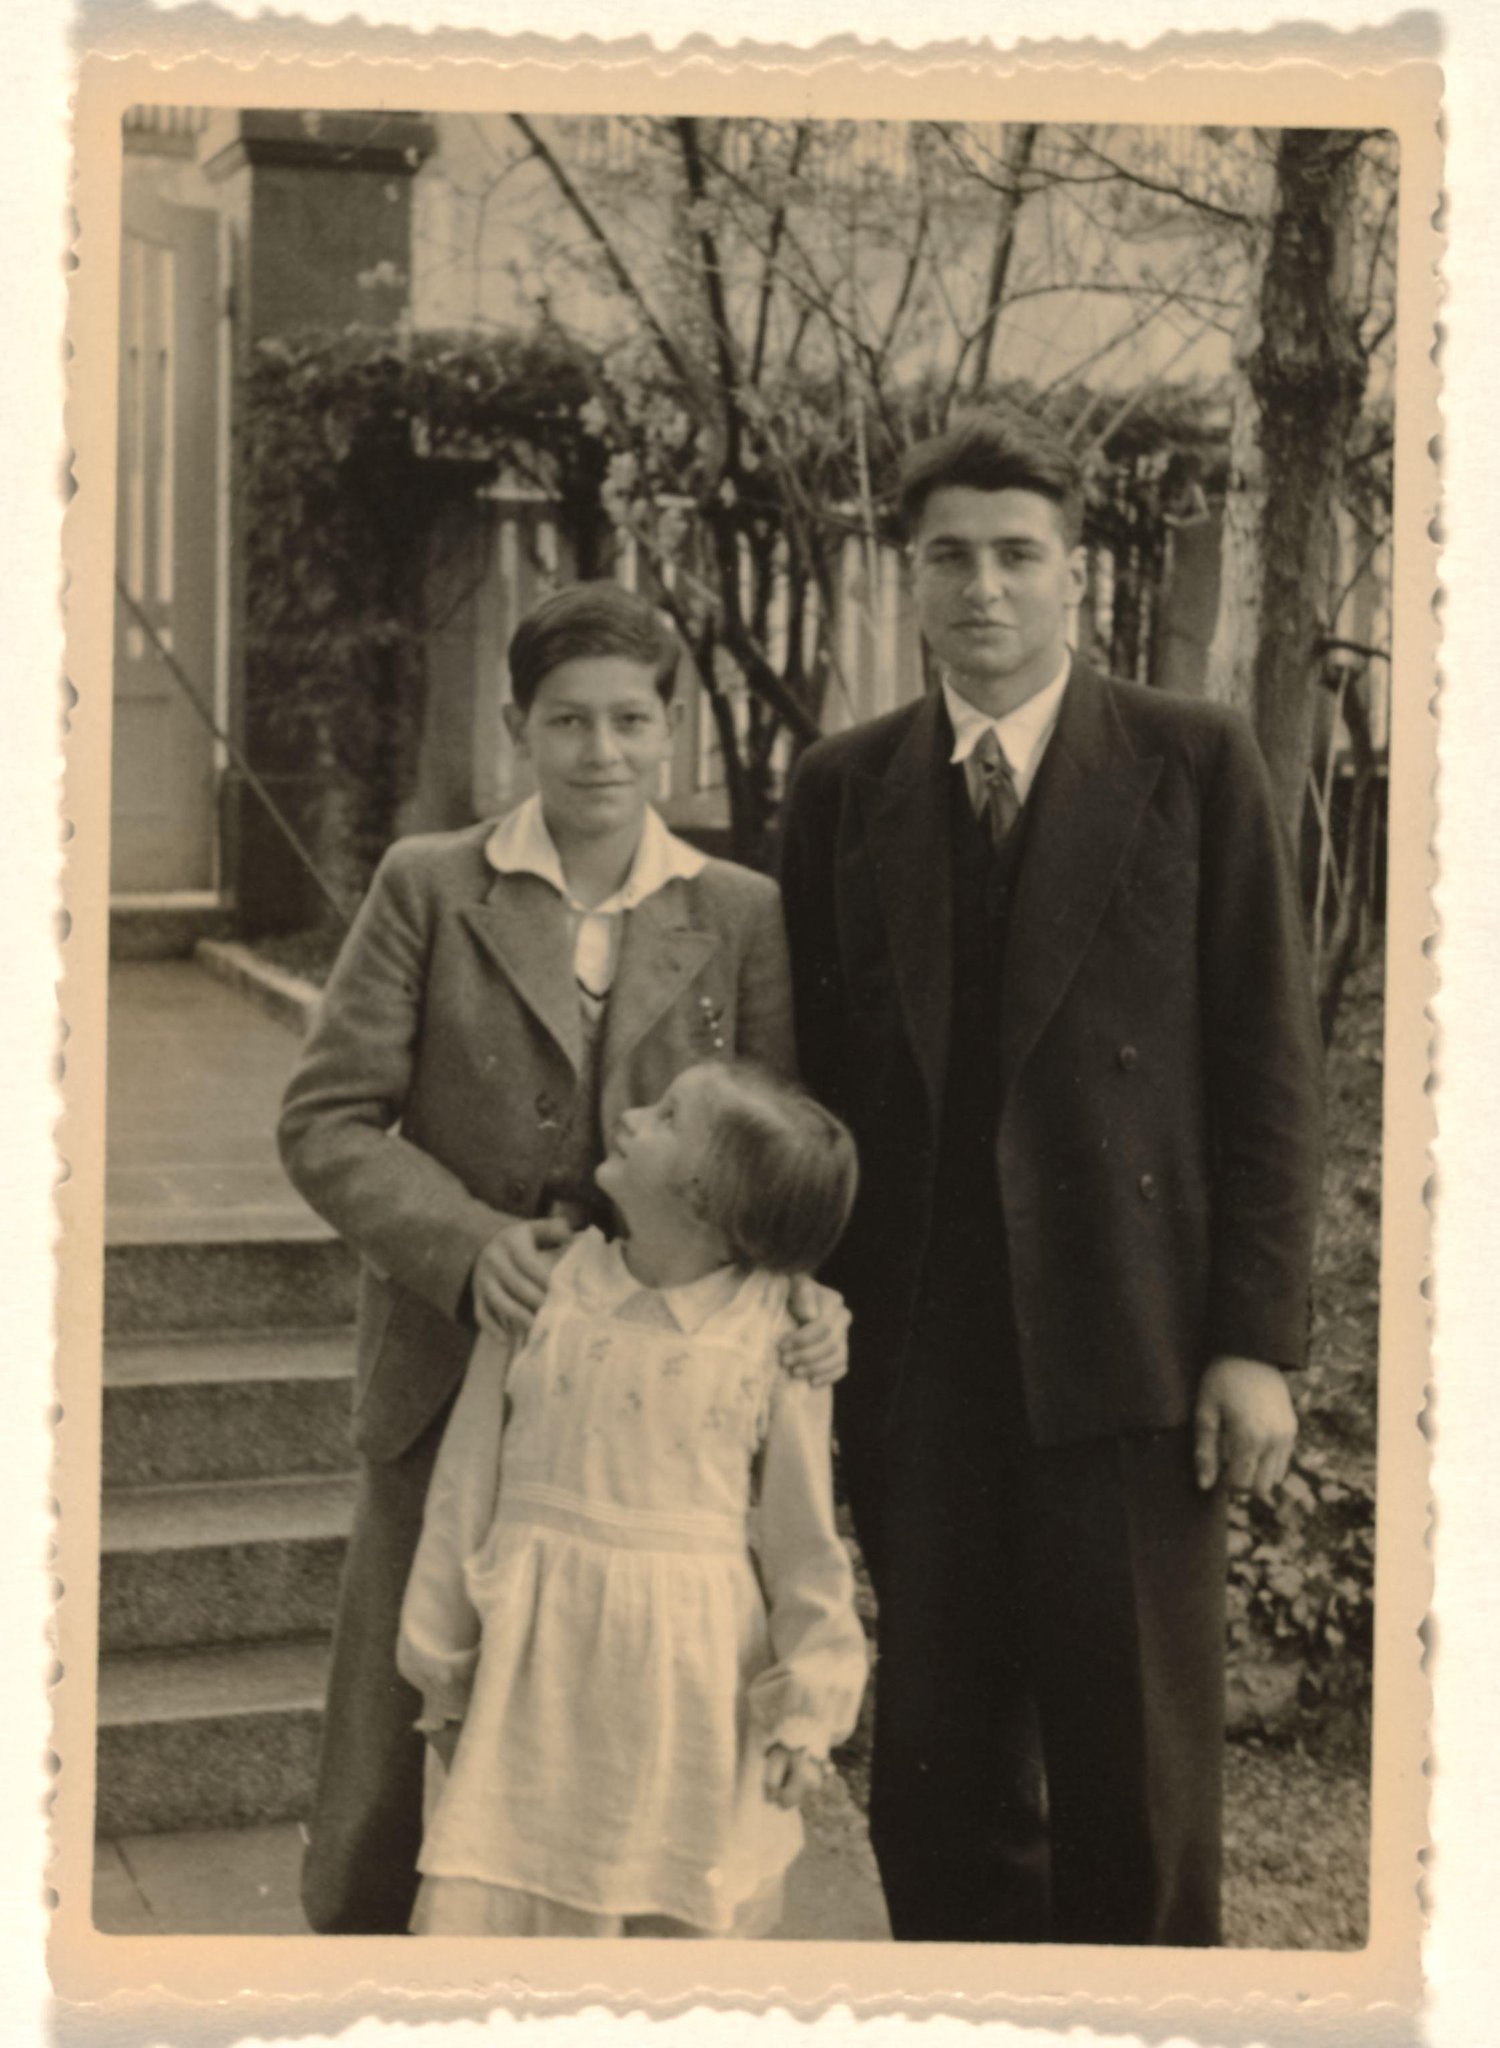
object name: photograph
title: Isabel Wachenheimer haar neven Klaus en Werner Zürndorfer, in de tuin van de familie Wachenheimer in Stuttgart, 1935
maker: Anonymous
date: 1935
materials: photographic support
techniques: gelatin silver print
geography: stuttgart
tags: leiden, isabel wachenheimer-elon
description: Isabel Wachenheimer (midden) haar neven Klaus (rechts) en Werner Zürndorfer (links), in de tuin van de familie Wachenheimer in Stuttgart.